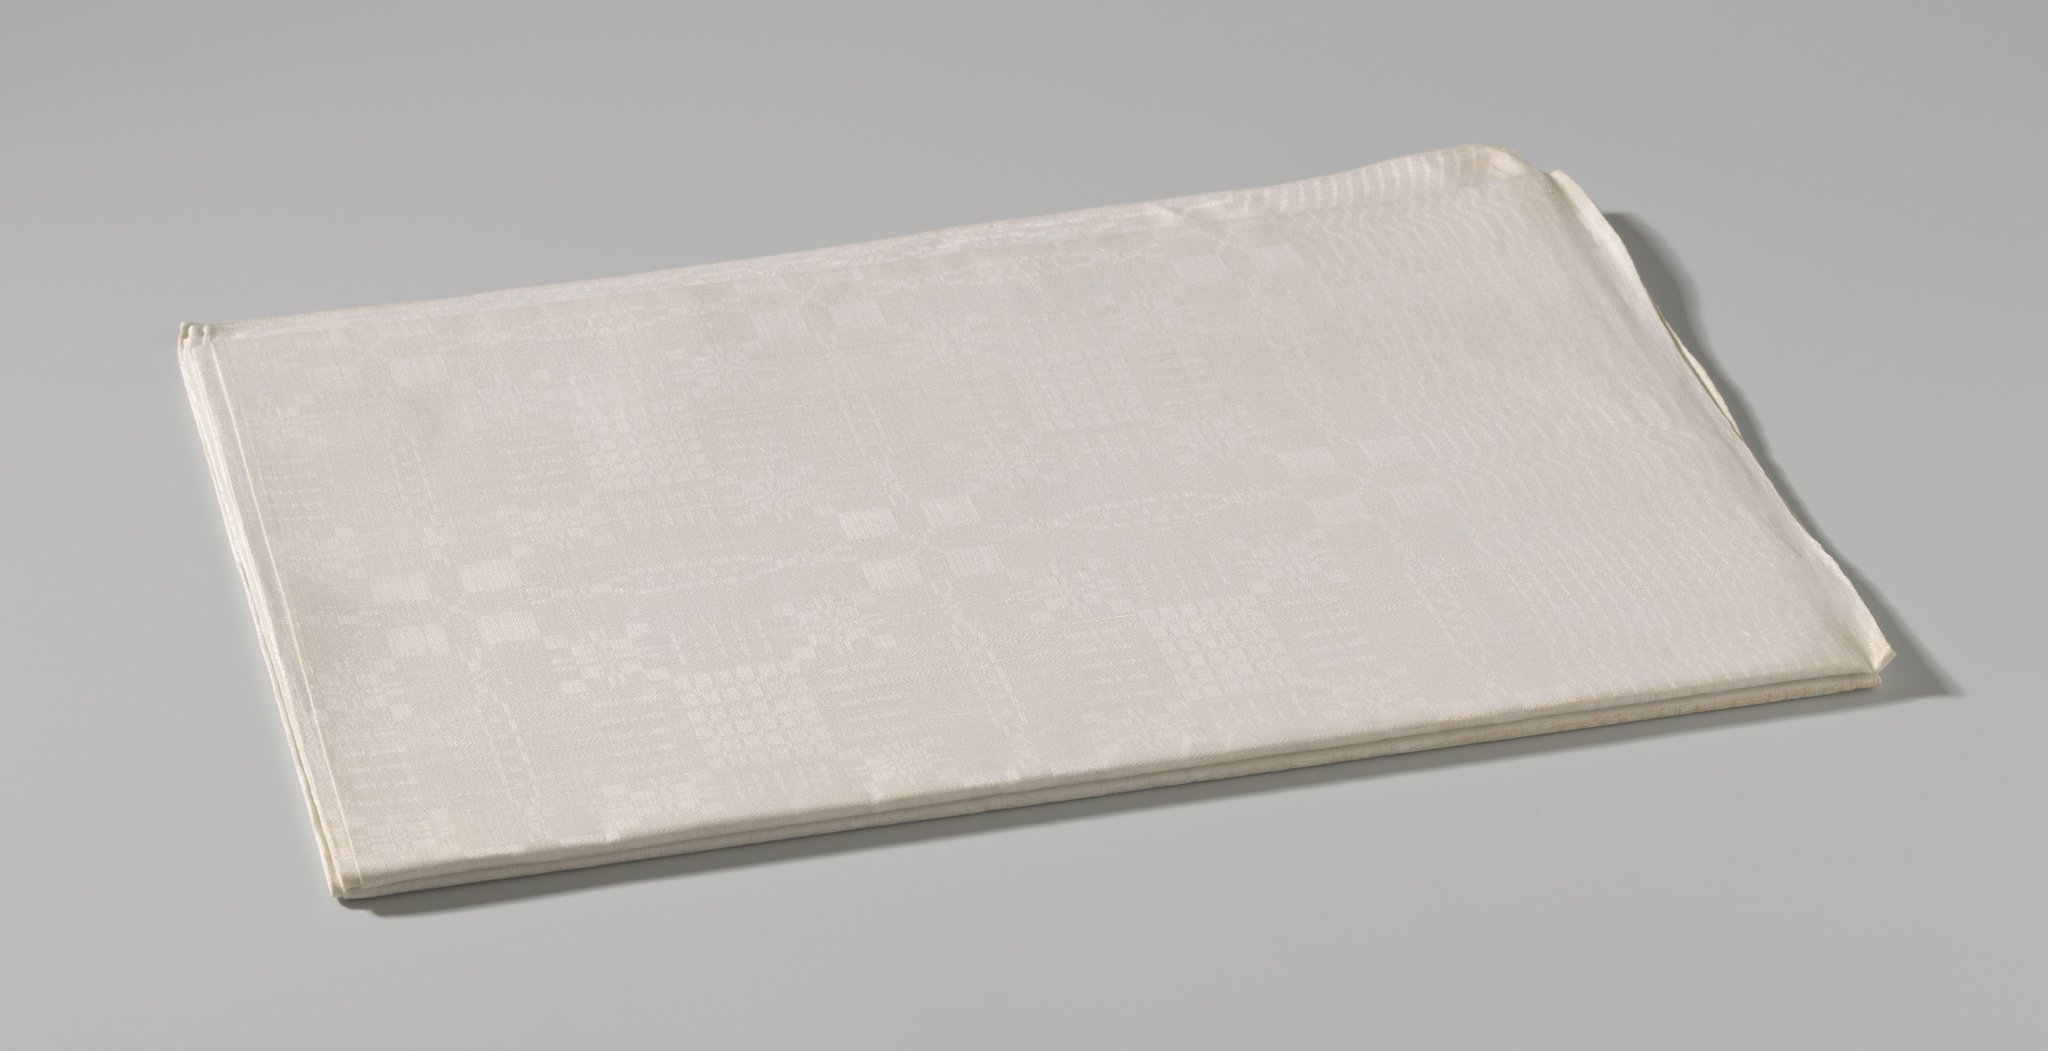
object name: tablecloth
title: Tafellaken van linnen pellendamast.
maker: Anonymous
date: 1400-1950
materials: linen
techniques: weave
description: Tafellaken van linnen pellendamast. Het geometrische patroon heeft uit ellipsen bestaande lijnen die vierkanten vormen. Op de kruispunten vier vierkanten en in de ontstane vierkante velden vierkanten opgebouwd uit geblokte vierkanten en lijnen. De randen zijn gestreept.